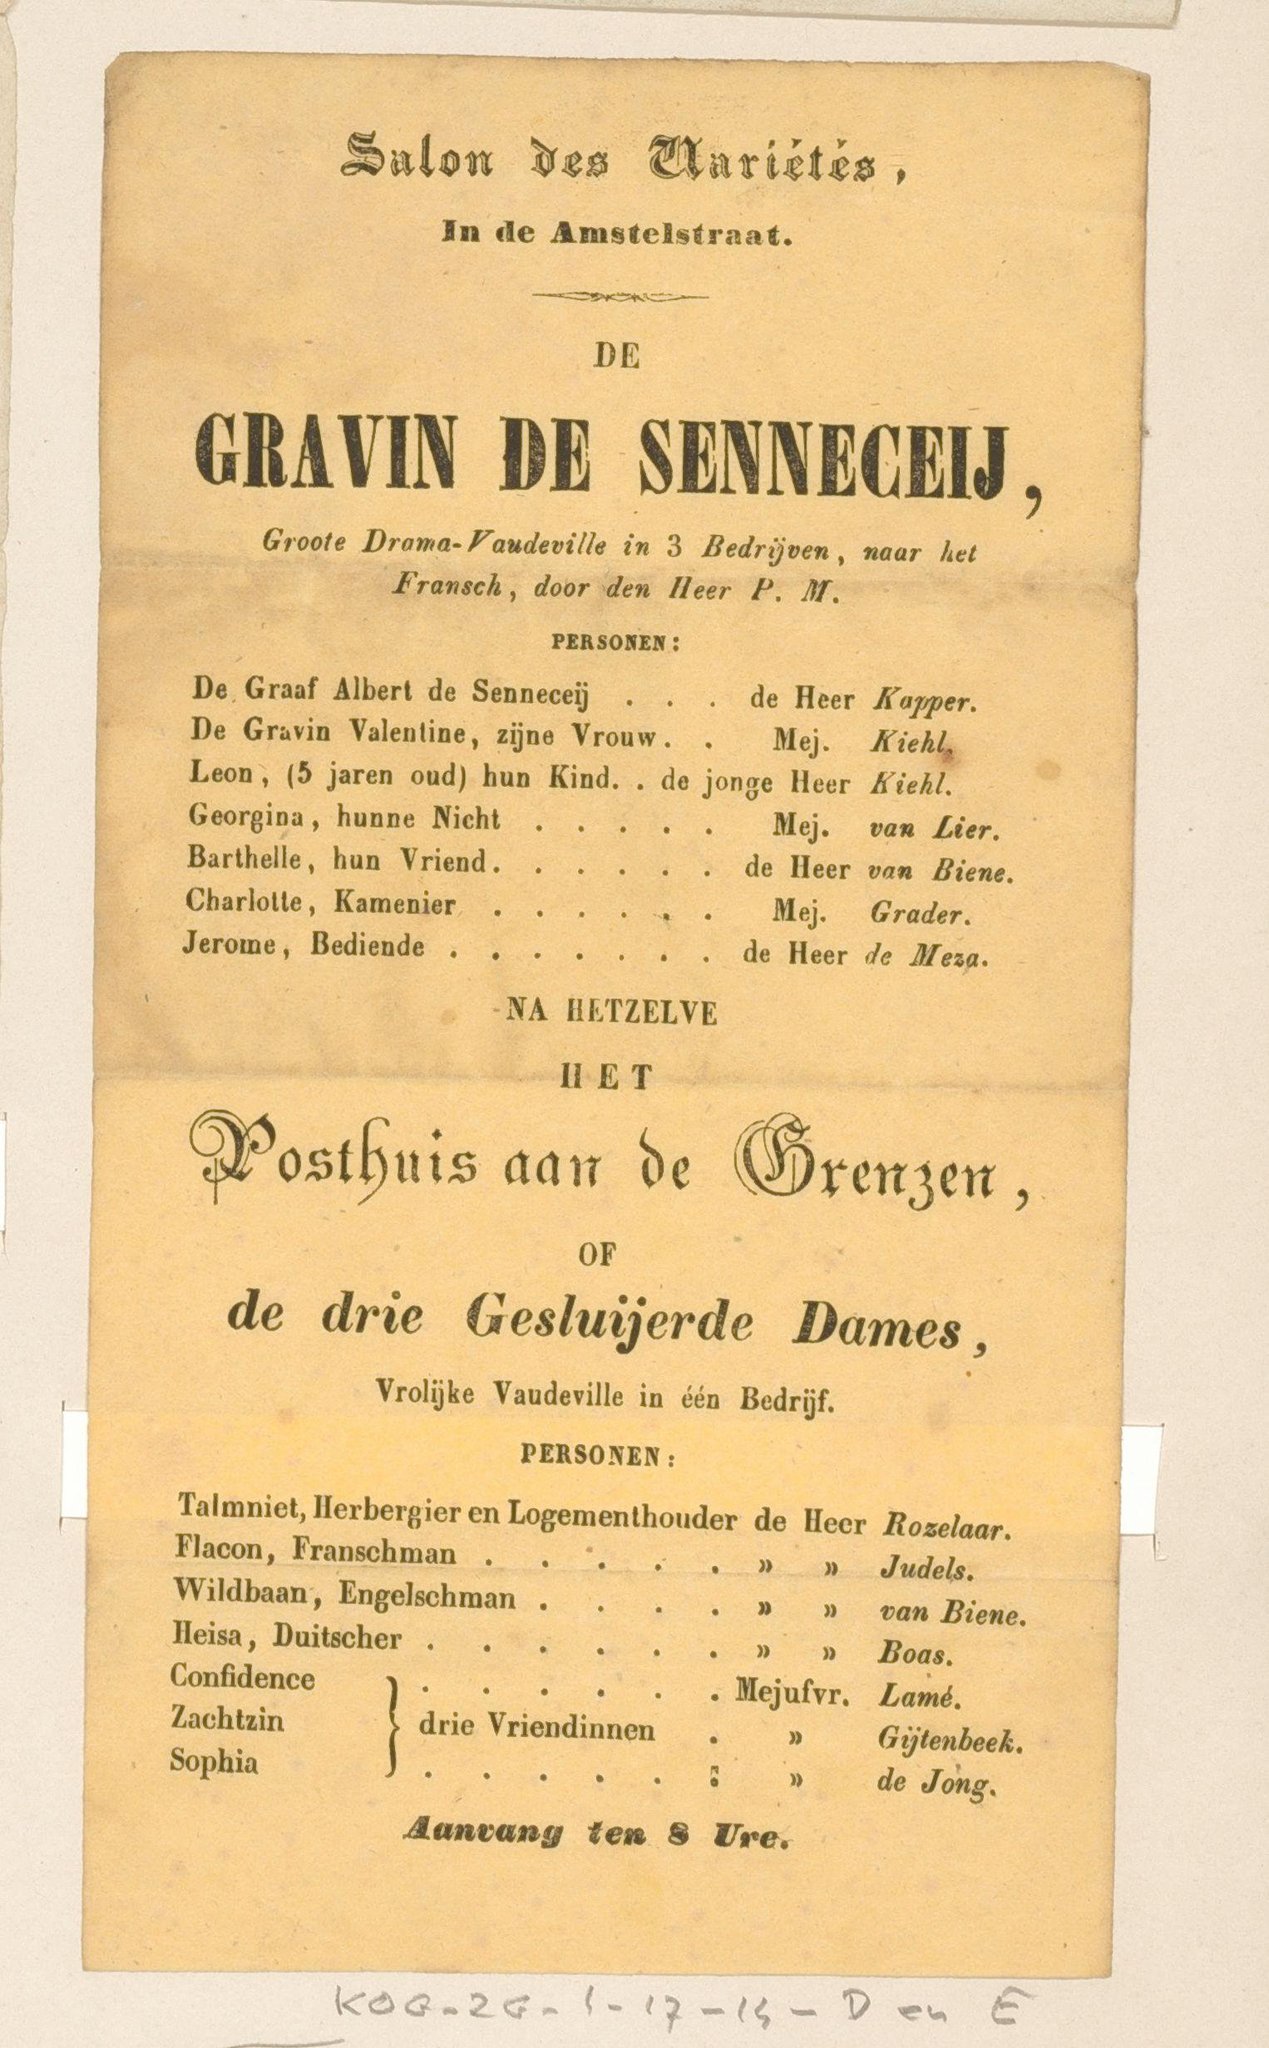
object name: text sheet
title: Programma van de voorstelling Gravin De Senneceij en Posthuis aan de Grenzen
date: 1850-1870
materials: paper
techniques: letterpress printing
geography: amsterdam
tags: theatre, theatrical performance, art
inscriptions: stamp, collector's mark: Lugt 1641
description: Programma van de voorstelling Gravin De Senneceij en Posthuis aan de Grenzen in de Salon de Variétés. Onderwerpsrubrieken binnen de Atlas Zeden en Gewoonten: Tooneel, Toneelprogramma’s.